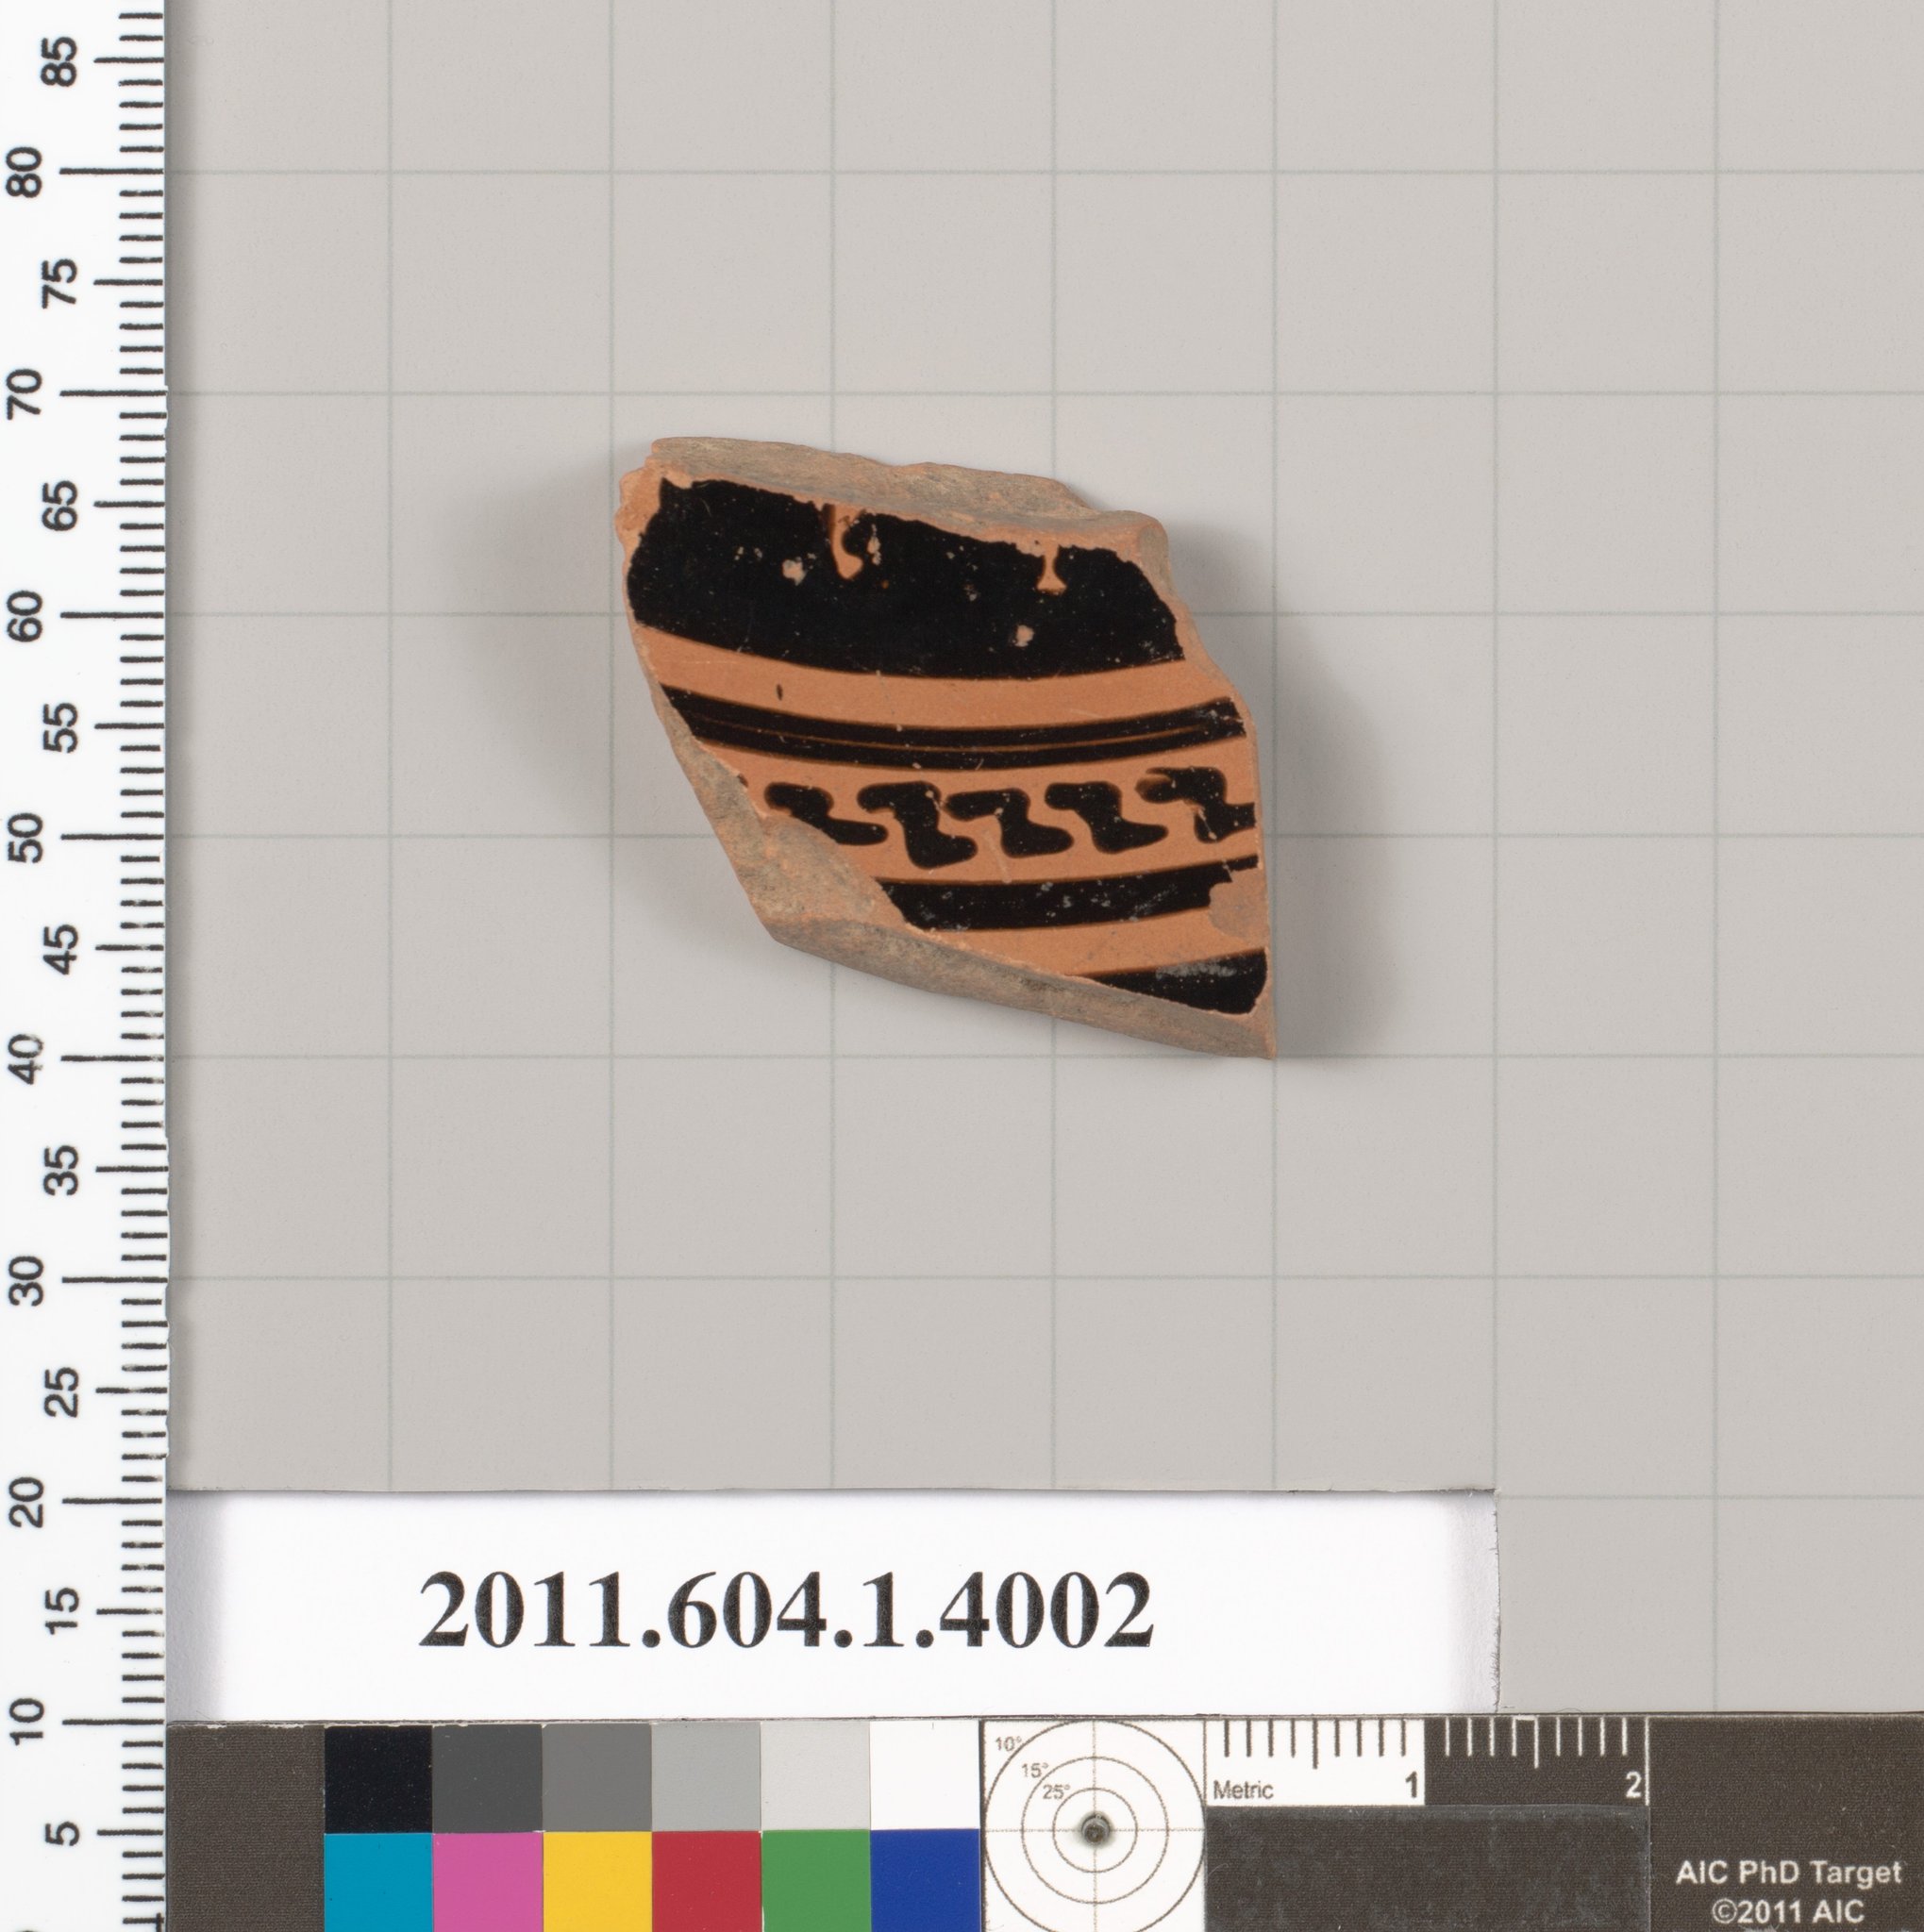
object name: kylix fragment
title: Terracotta fragment of a kylix (drinking cup)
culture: greek, attic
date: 475-451 BCE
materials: terracotta